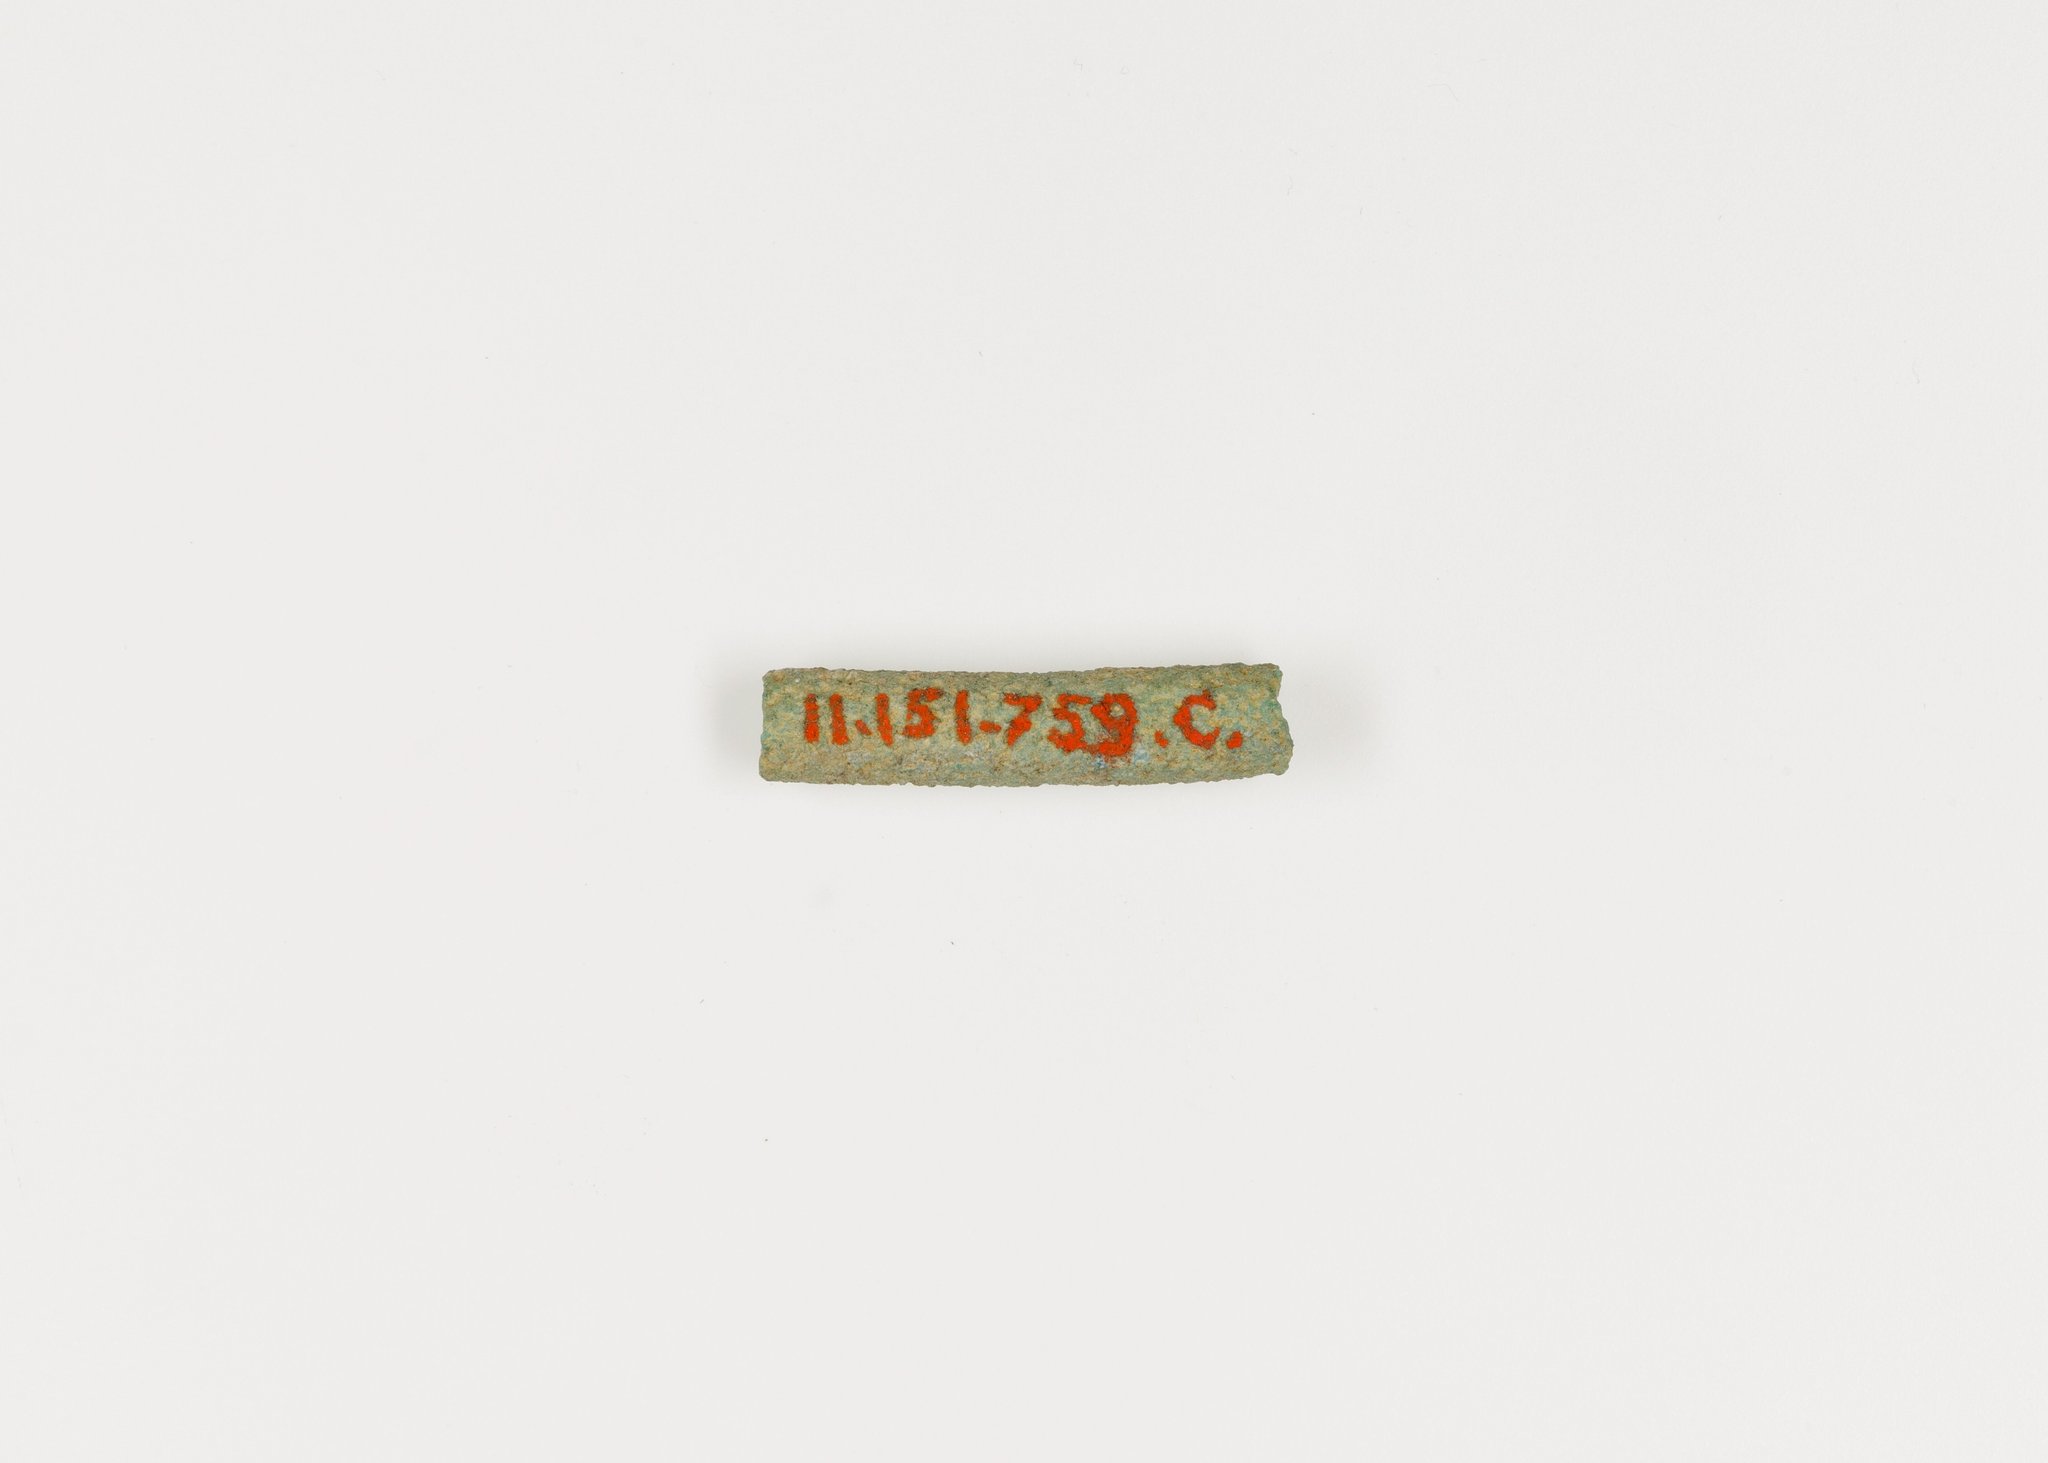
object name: bead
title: Tubular bead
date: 1802-1640 BCE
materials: faience